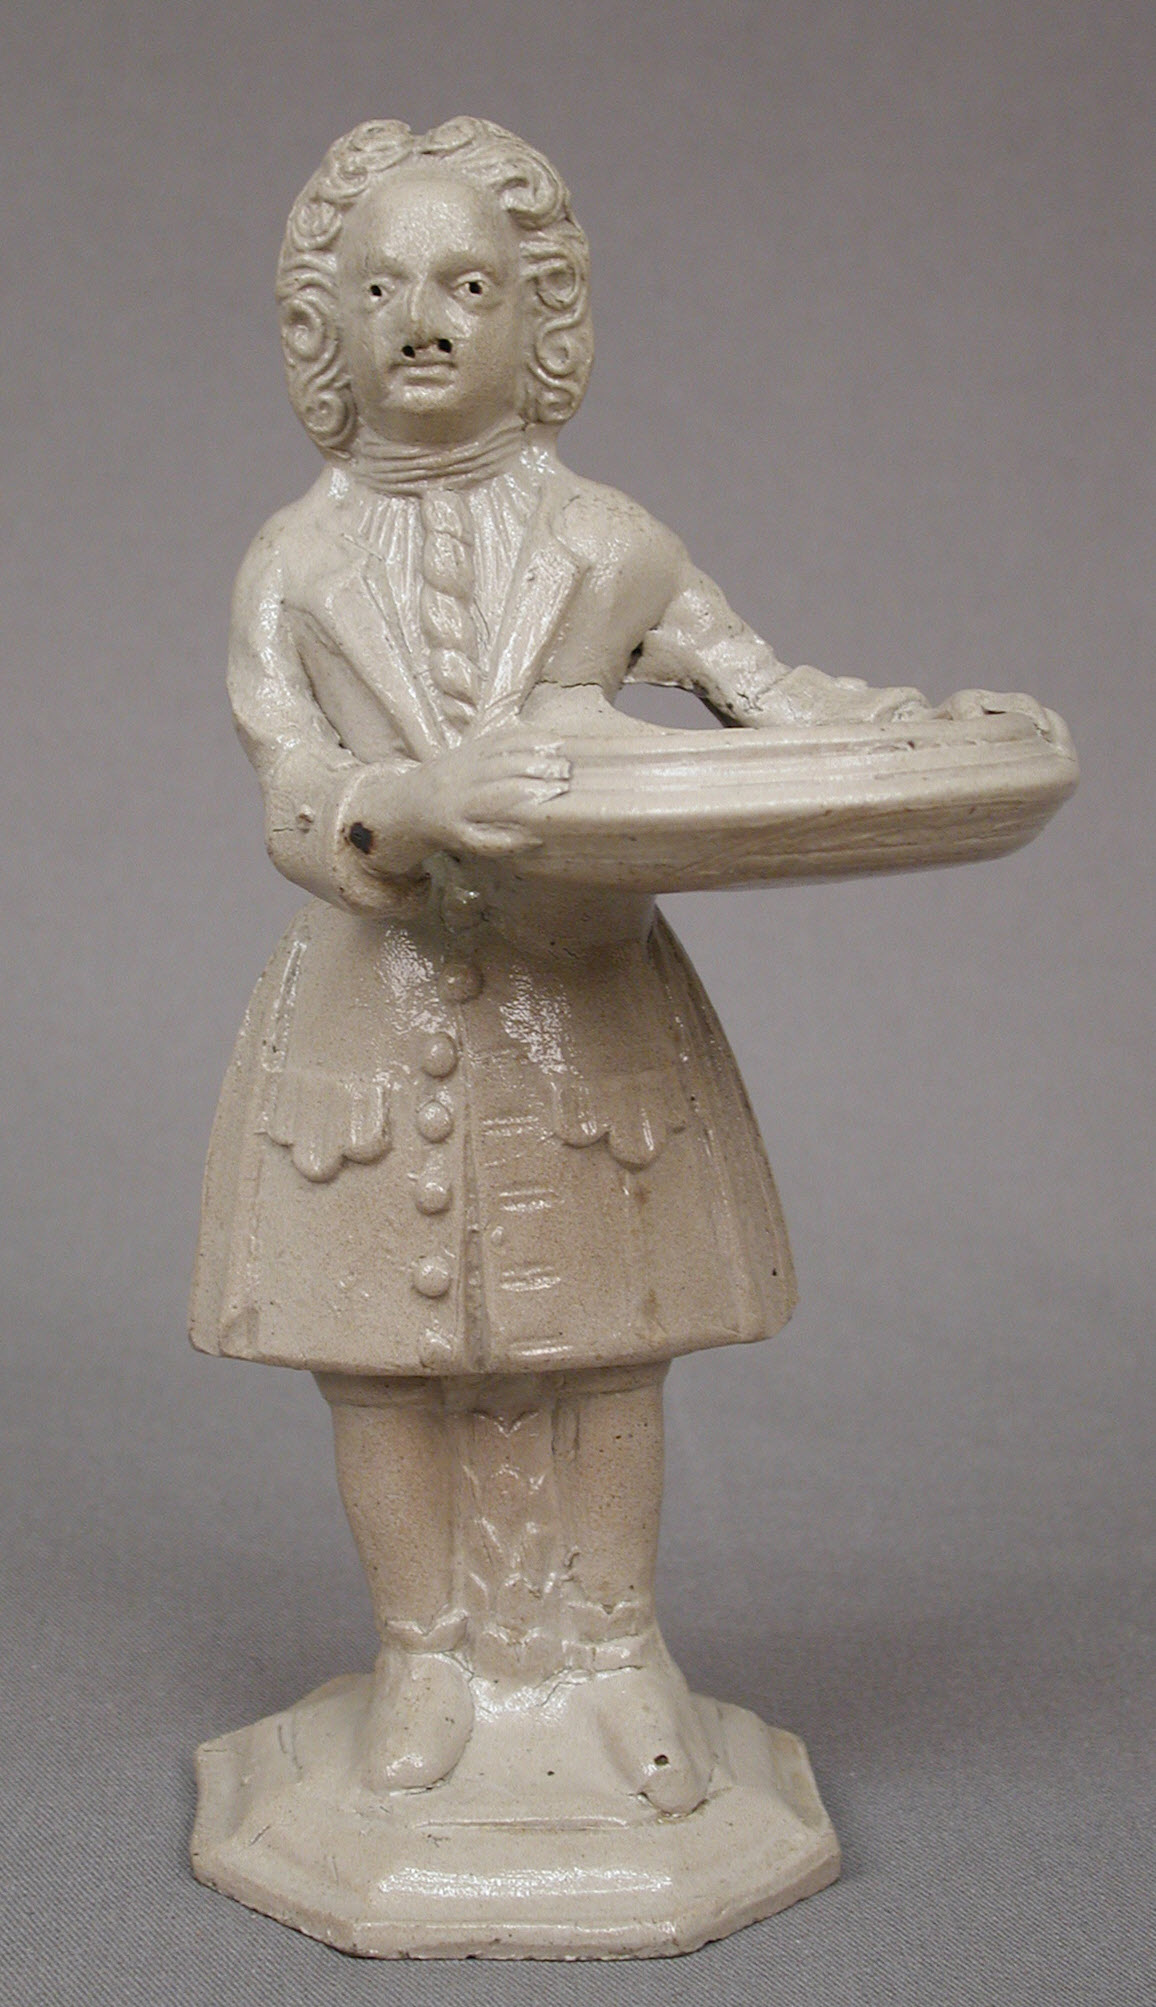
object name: sand container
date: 1701-1800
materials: stoneware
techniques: salt glaze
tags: men